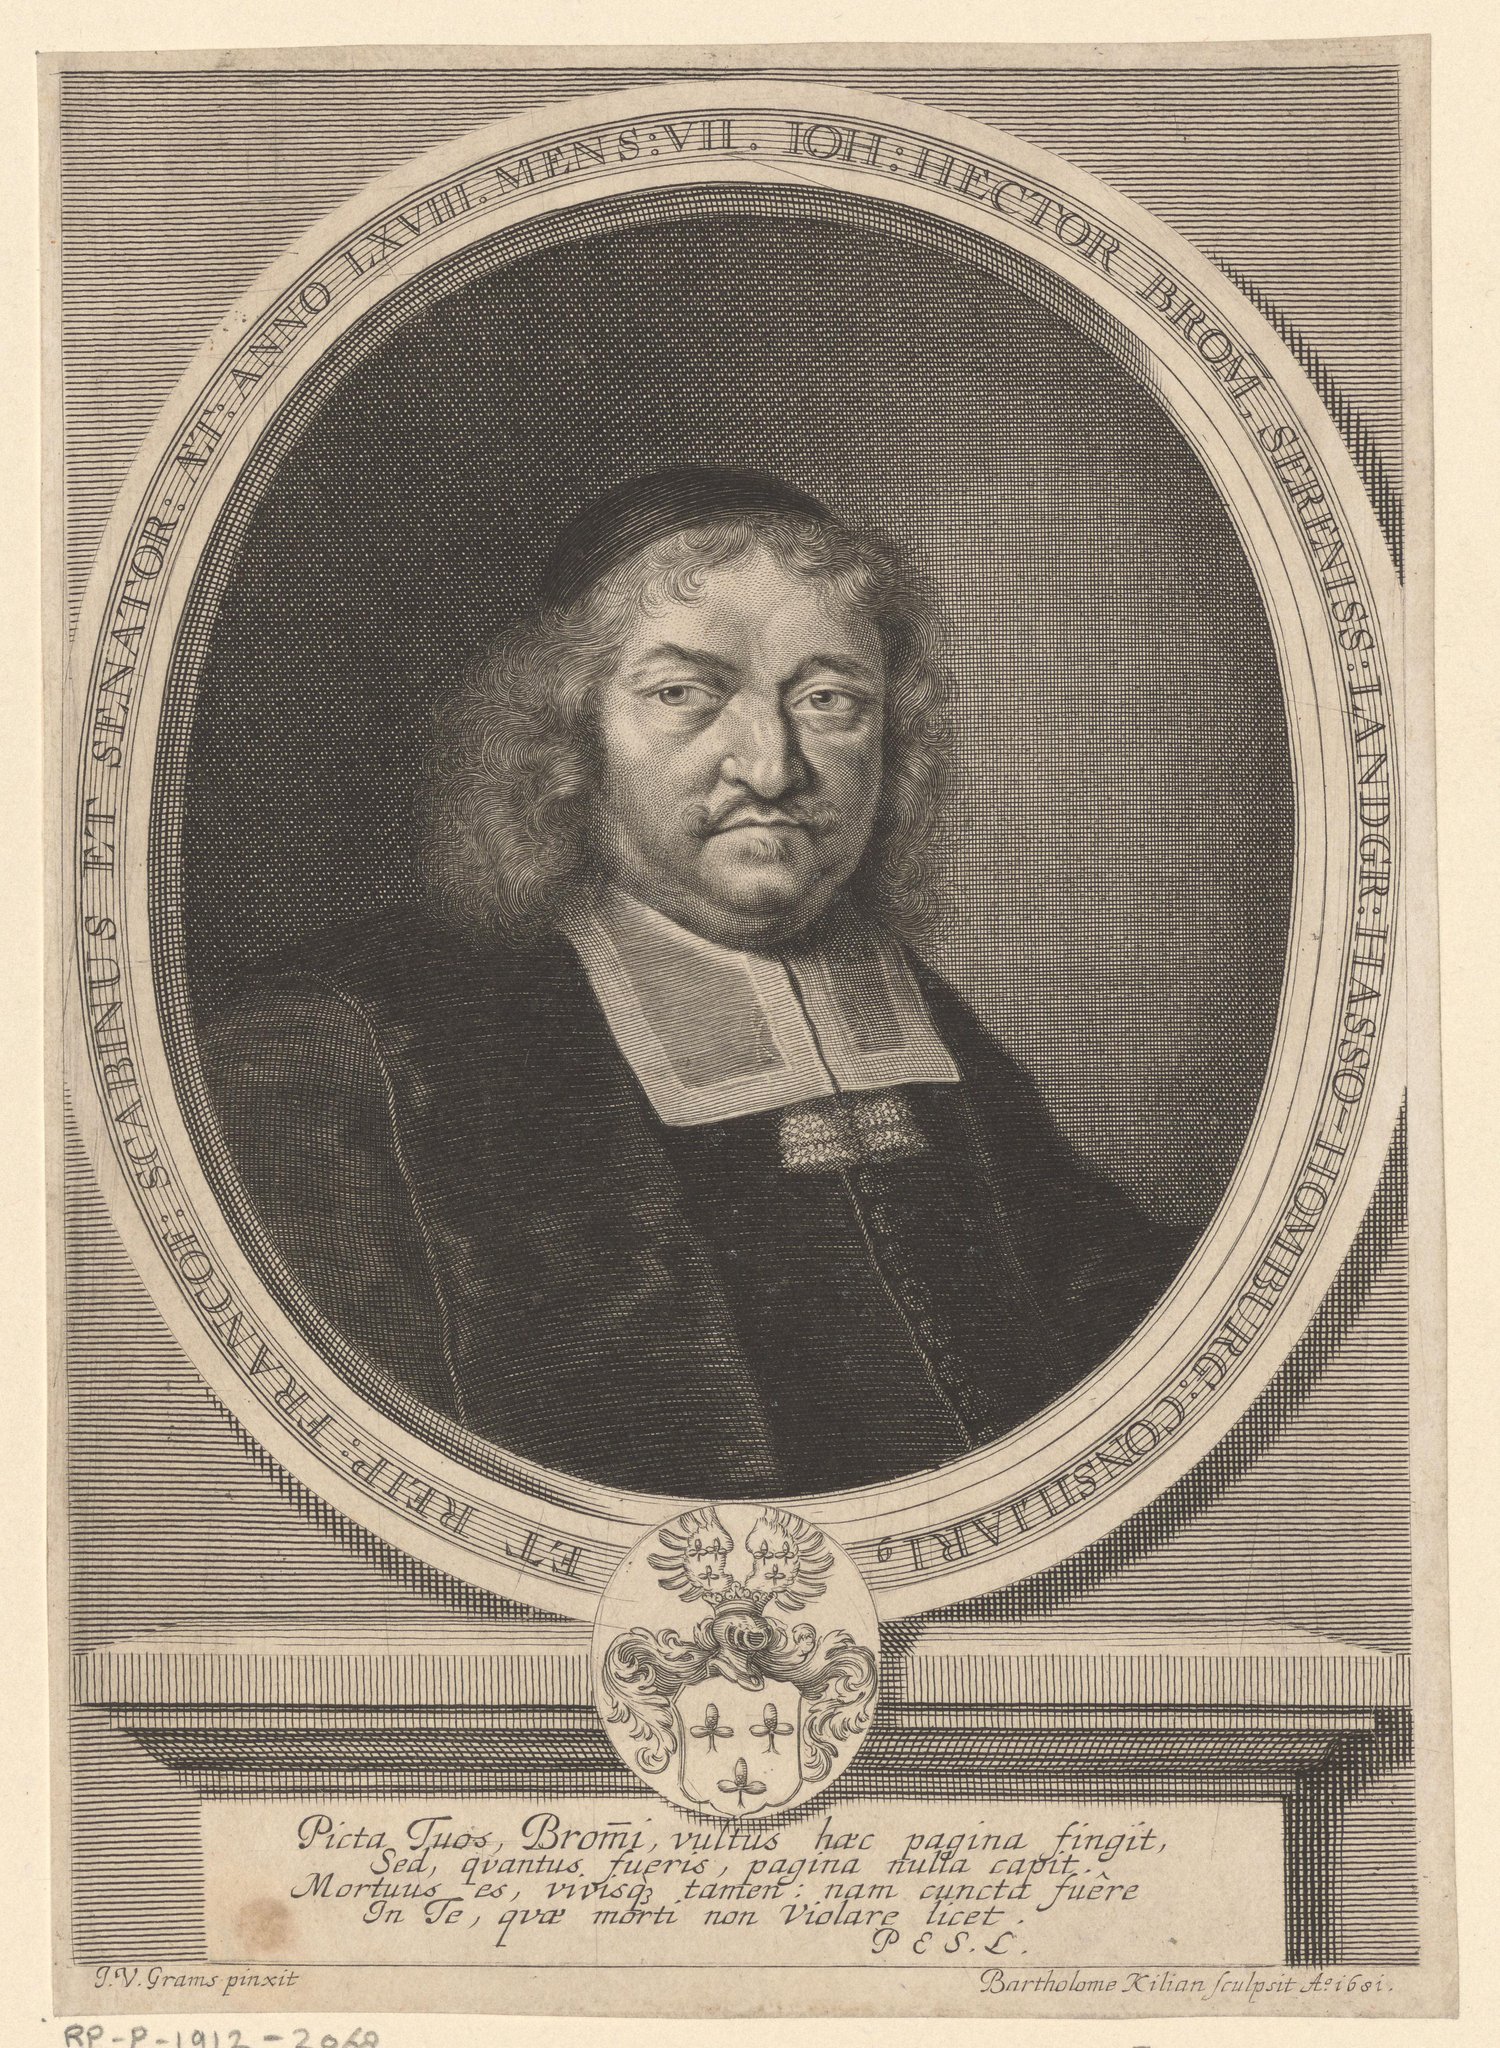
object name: print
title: Portret van Johann Hektor Bromm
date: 1681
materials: paper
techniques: engraving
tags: historical persons, armorial bearing, heraldry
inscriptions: collector's mark: Lugt 2228